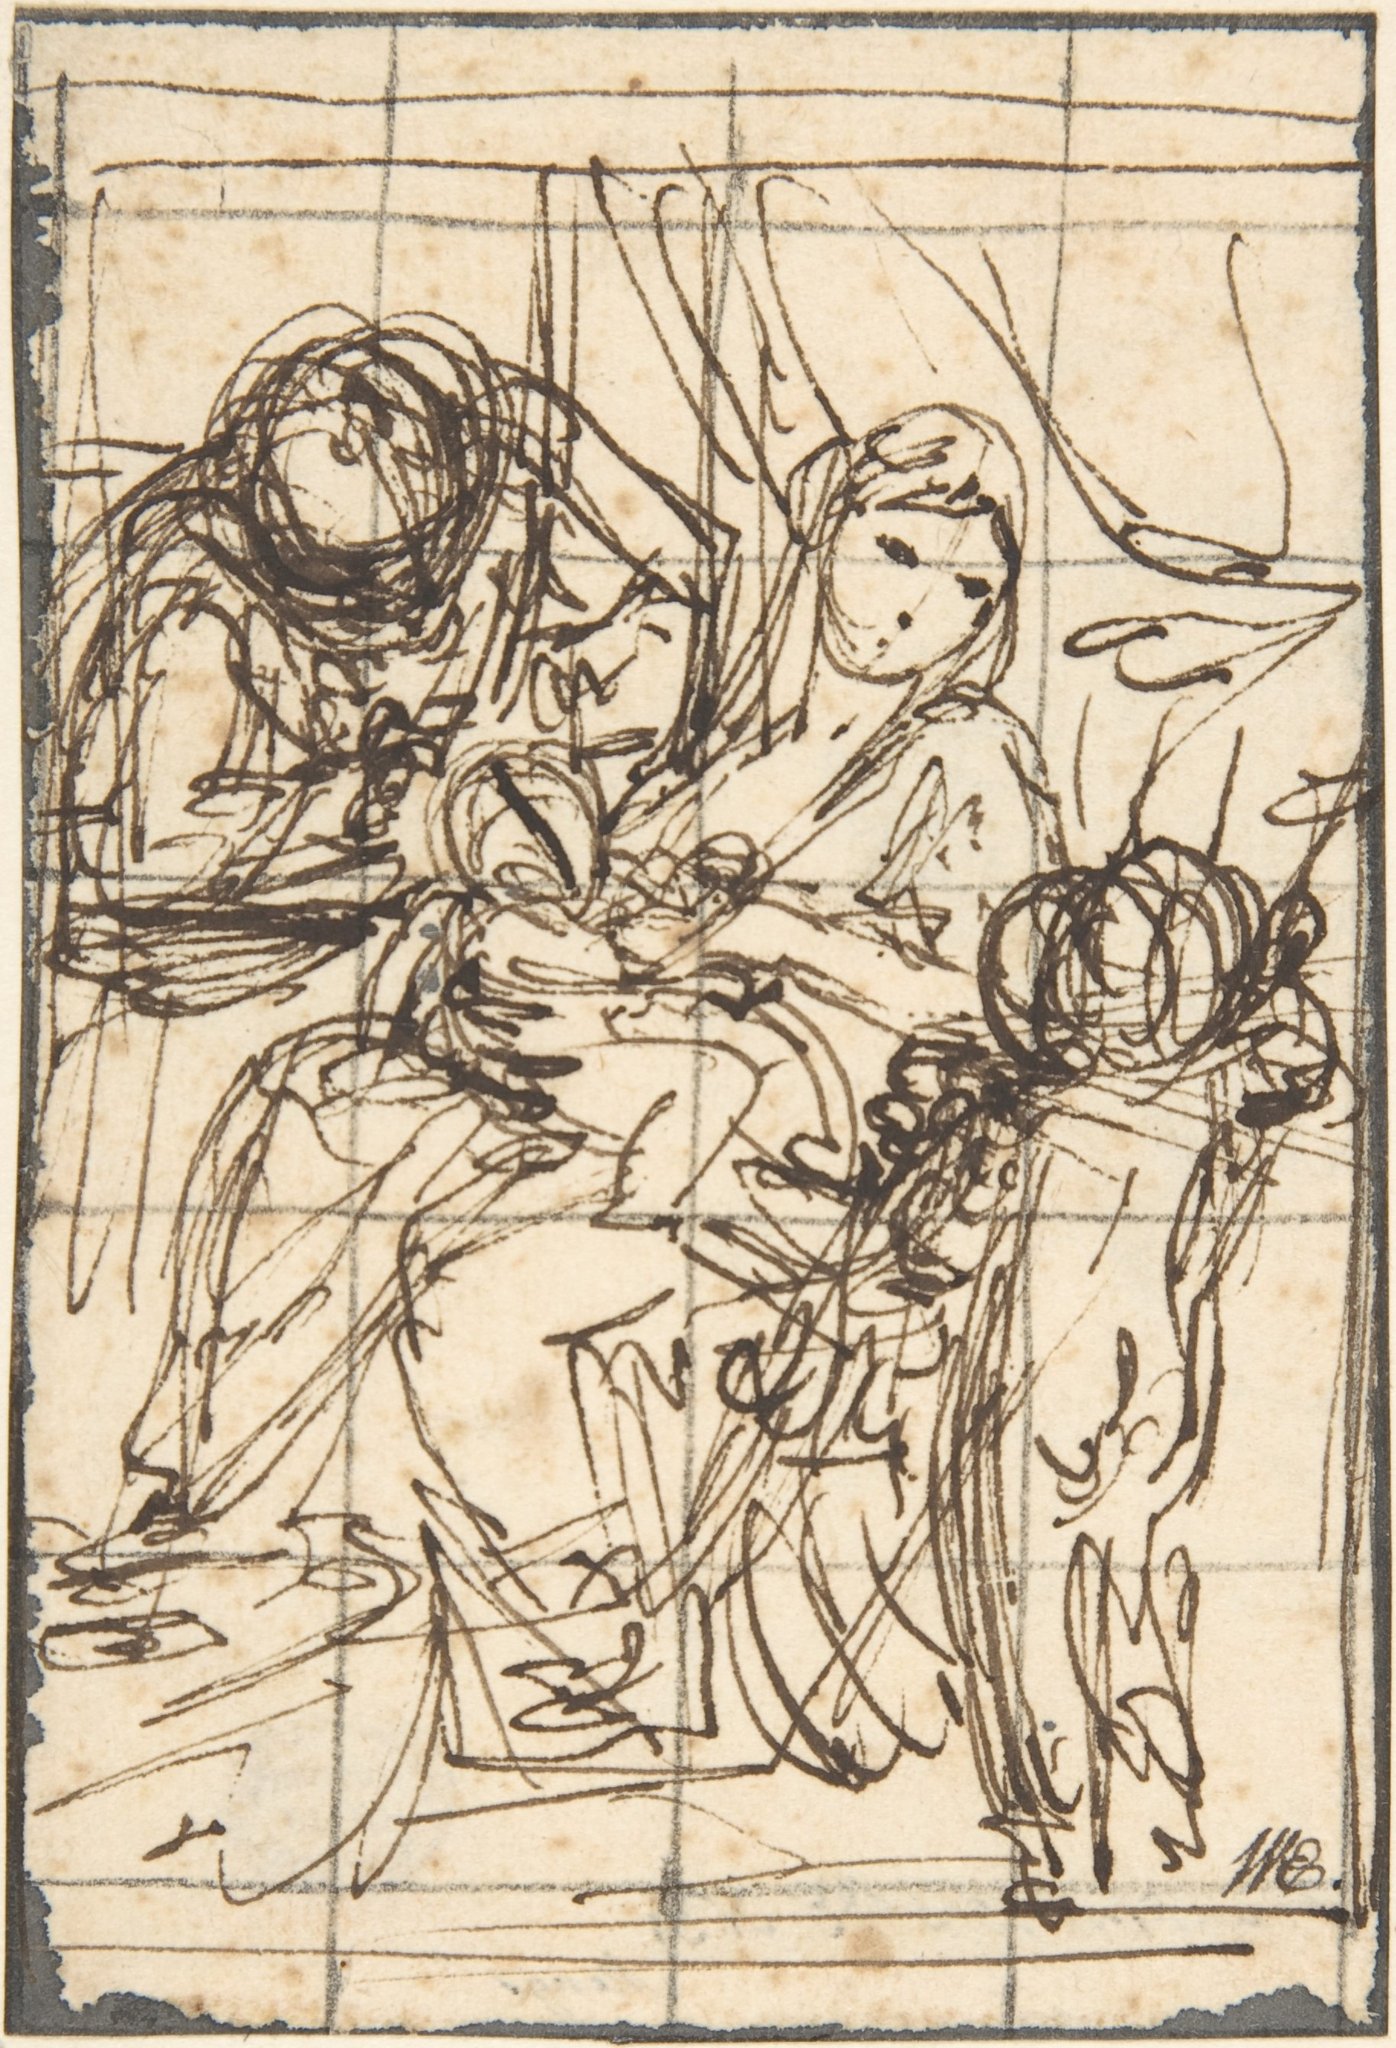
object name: drawing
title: Holy Family with St. John the Baptist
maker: anton raphael mengs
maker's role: artist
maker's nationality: german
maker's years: 1728-1779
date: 1734-1766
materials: chalk, ink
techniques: pen, drawing, transfer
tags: holy family,saint john the baptist